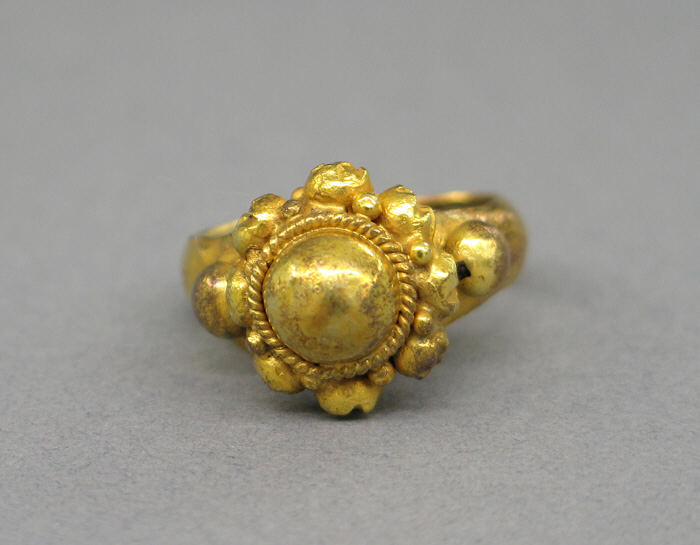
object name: ring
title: Ring with Large Central Boss Flanked by Series of Same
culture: indonesian, javanese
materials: gold